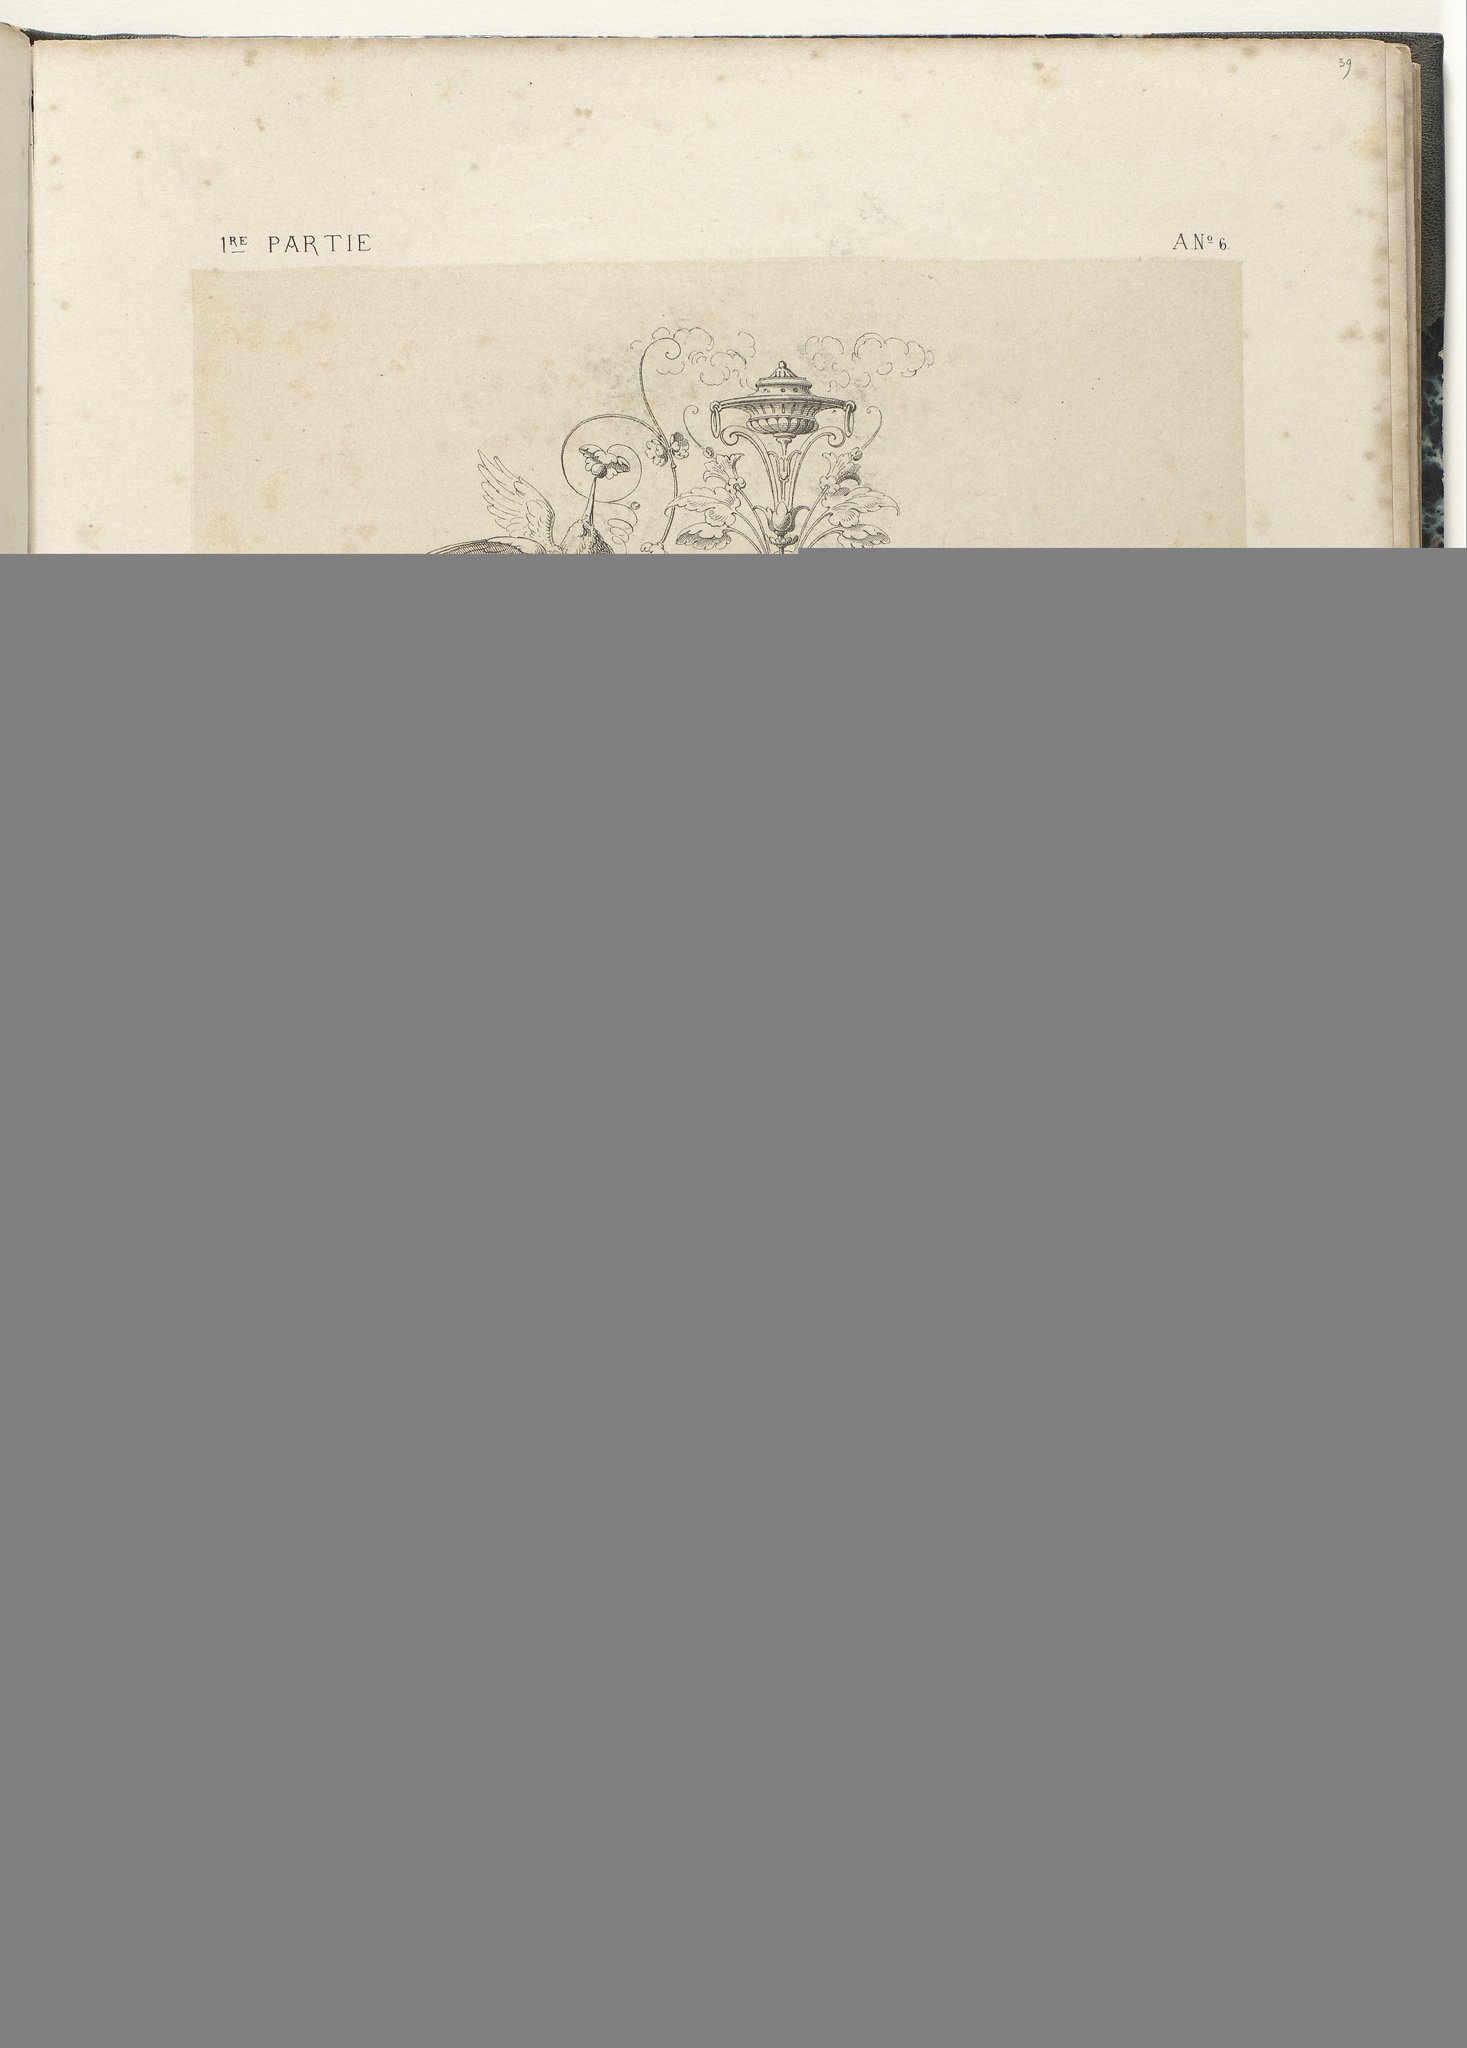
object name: print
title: Ornament met gevleugeld fantasiedier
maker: michel liénard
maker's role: print maker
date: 1866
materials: paper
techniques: tone lithography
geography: liège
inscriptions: annotation: ‘Motif v. drijfwerk, email en Edelgesteente.’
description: Linksboven pikt een vogel naar een bes. In de linkerhoek staat: 1re partie, rechtsboven: A. N° 6., rechtsonder: 14.